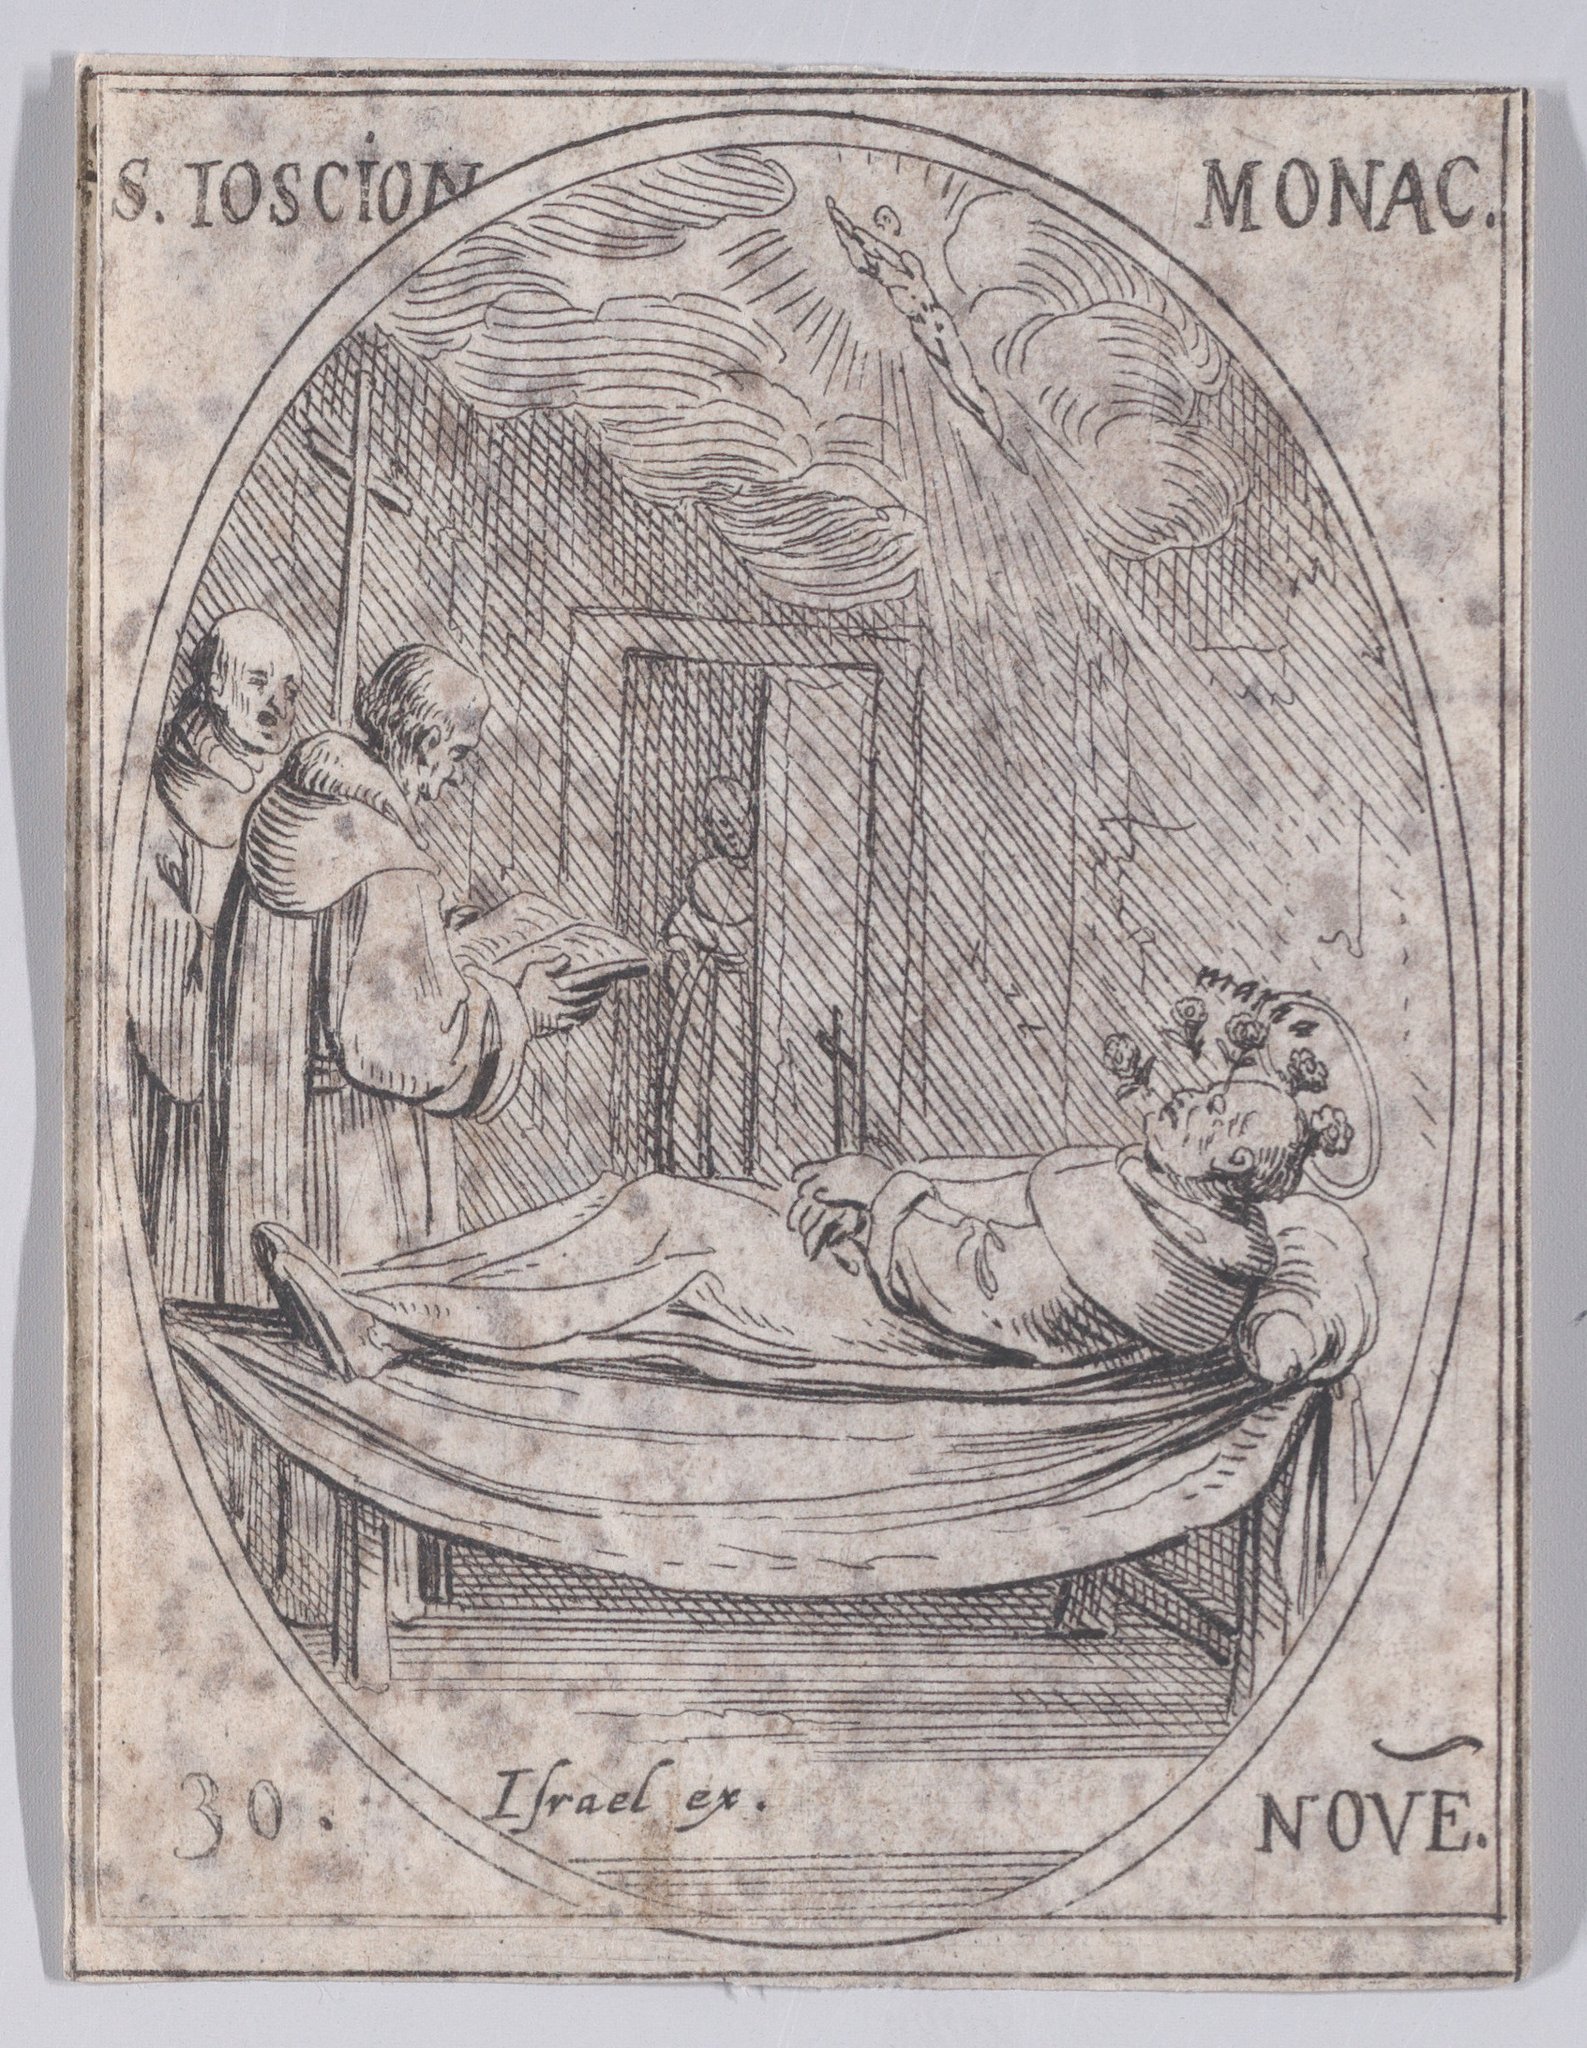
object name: print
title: S. Joscoin, moine (St. Joscius, Monk), November 30th, from "Les Images De Tous Les Saincts et Saintes de L'Année" (Images of All of the Saints and Religious Events of the Year)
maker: jacques callot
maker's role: artist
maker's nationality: french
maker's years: 1592-1635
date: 1636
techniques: etching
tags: men,saints